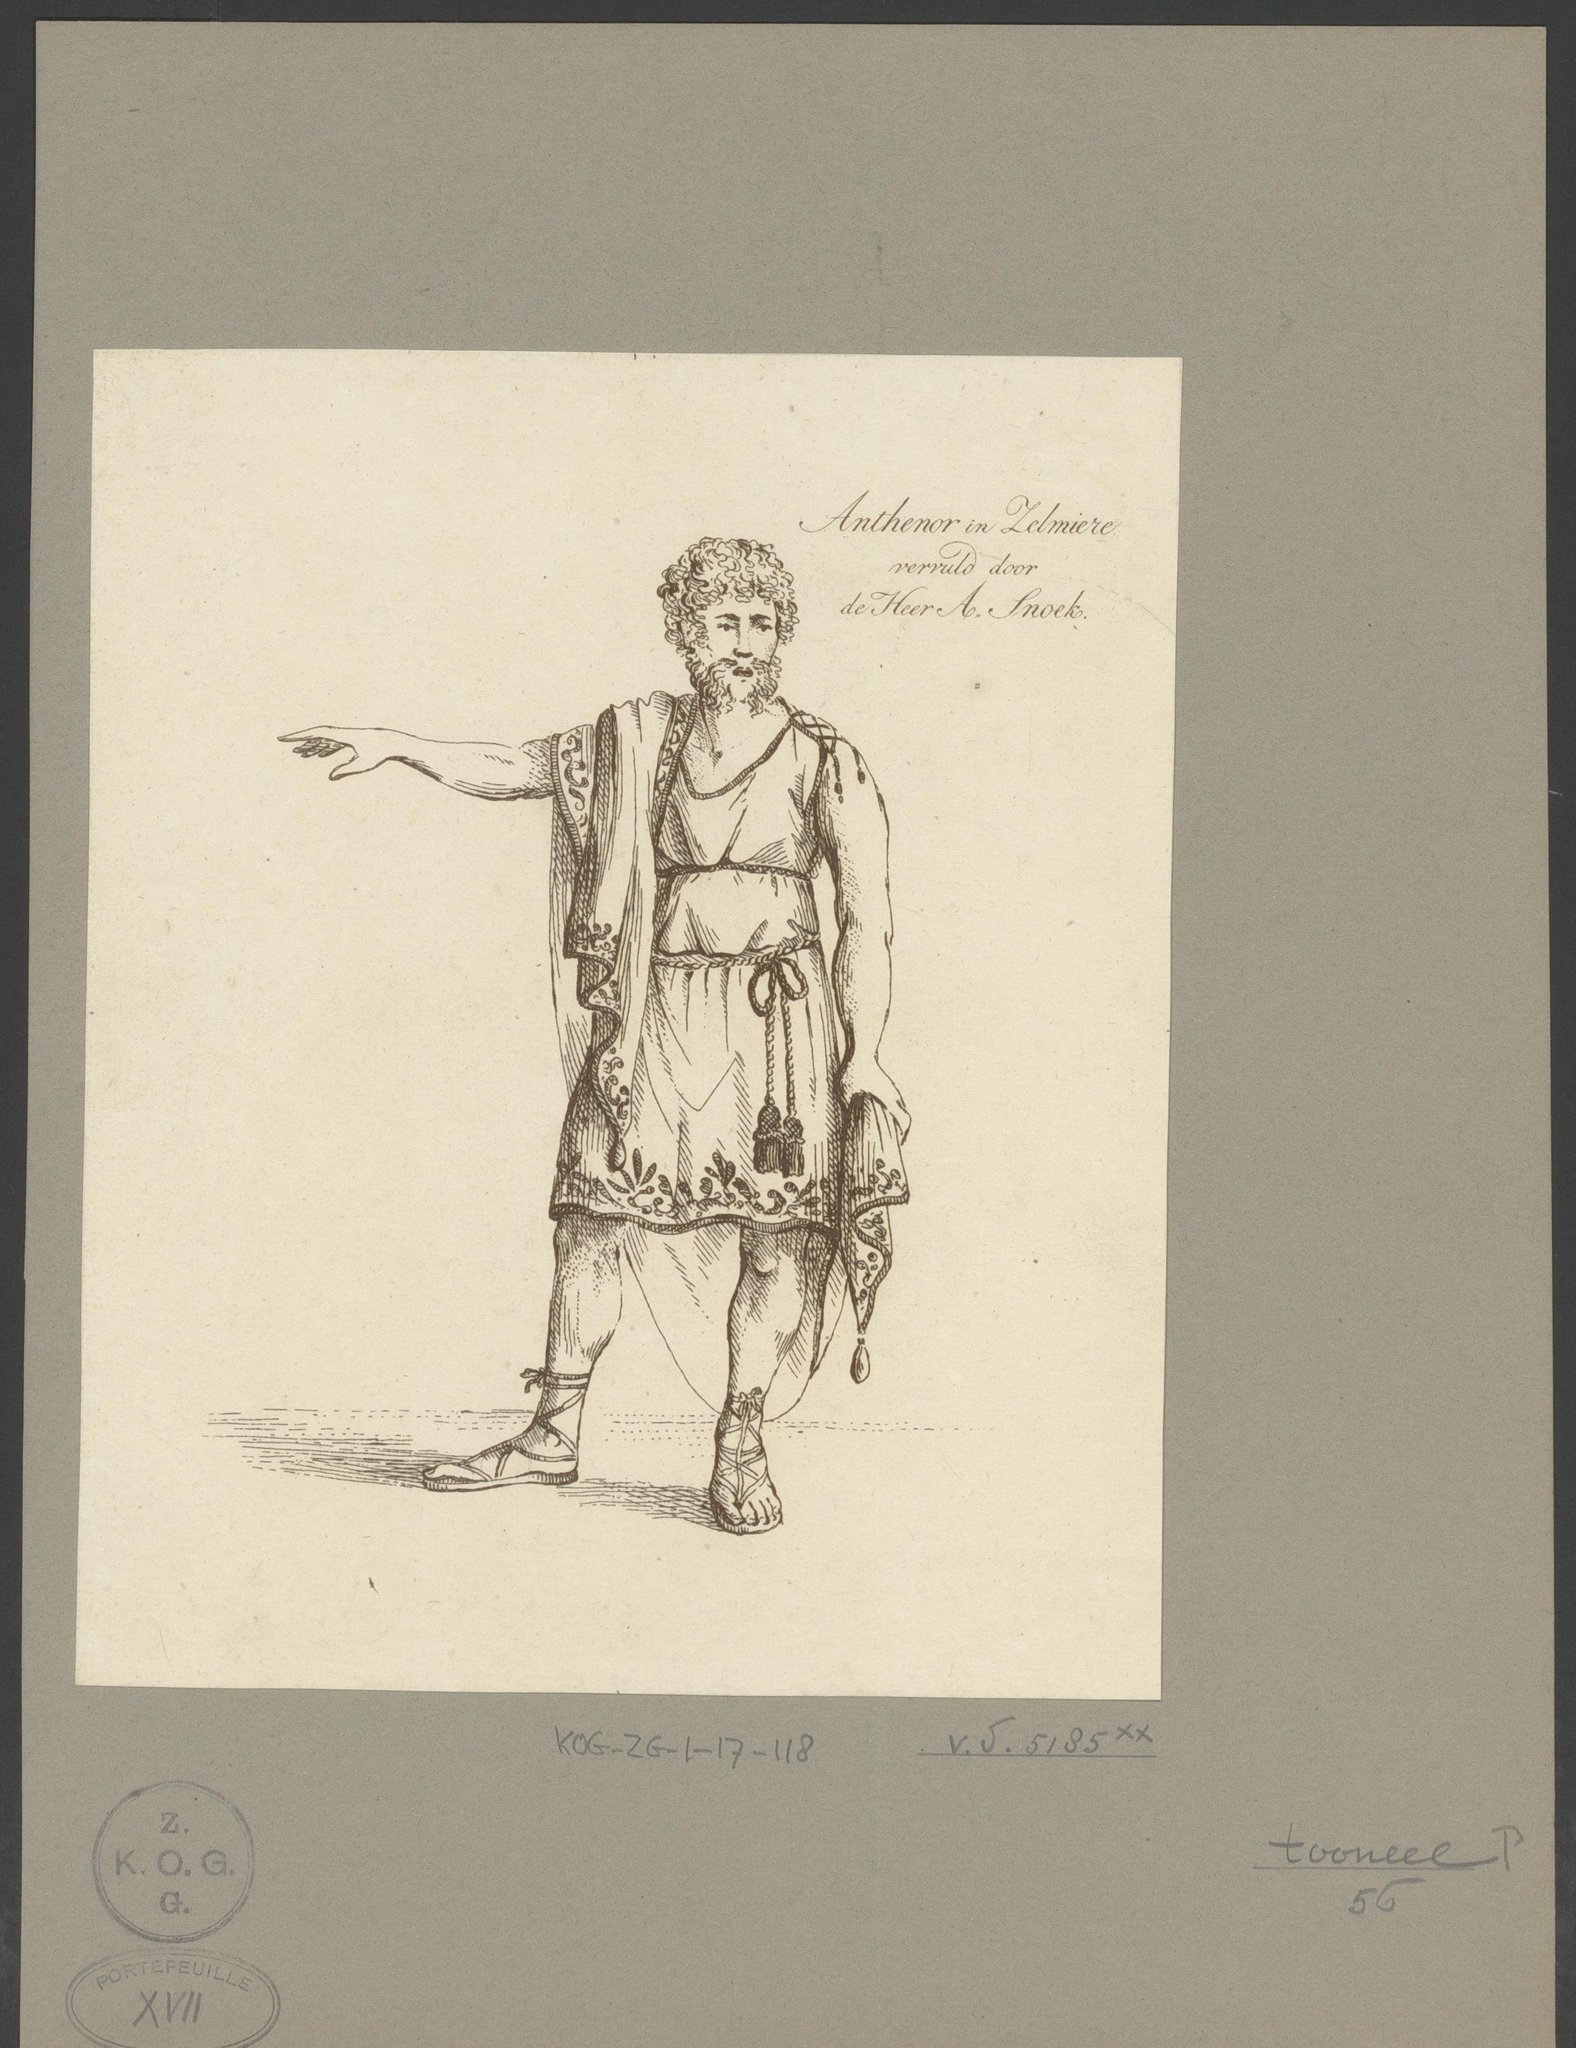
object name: print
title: Andreas Snoek in de rol van Anthenor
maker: johannes jelgerhuis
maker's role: draughtsman, painter, print maker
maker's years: 1770-1836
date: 1805-1836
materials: paper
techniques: etching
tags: rotterdam, actor (on the stage), historical persons (portraits and scenes from the life) (+ all kinds of 'portrait historié': mythological portrait, allegorical portrait, 'rollenporträt', etc.)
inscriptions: stamp, collector's mark: Lugt 1641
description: De acteur Andreas Snoek als Anthenor, gekleed in Romeinse toga, wijzend. Prent uit een serie van tien met Nederlandse acteurs en actrices in verschillende rollen. Onderwerpsrubrieken binnen de Atlas Zeden en Gewoonten: Tooneel, Portretten van toneelspelers.